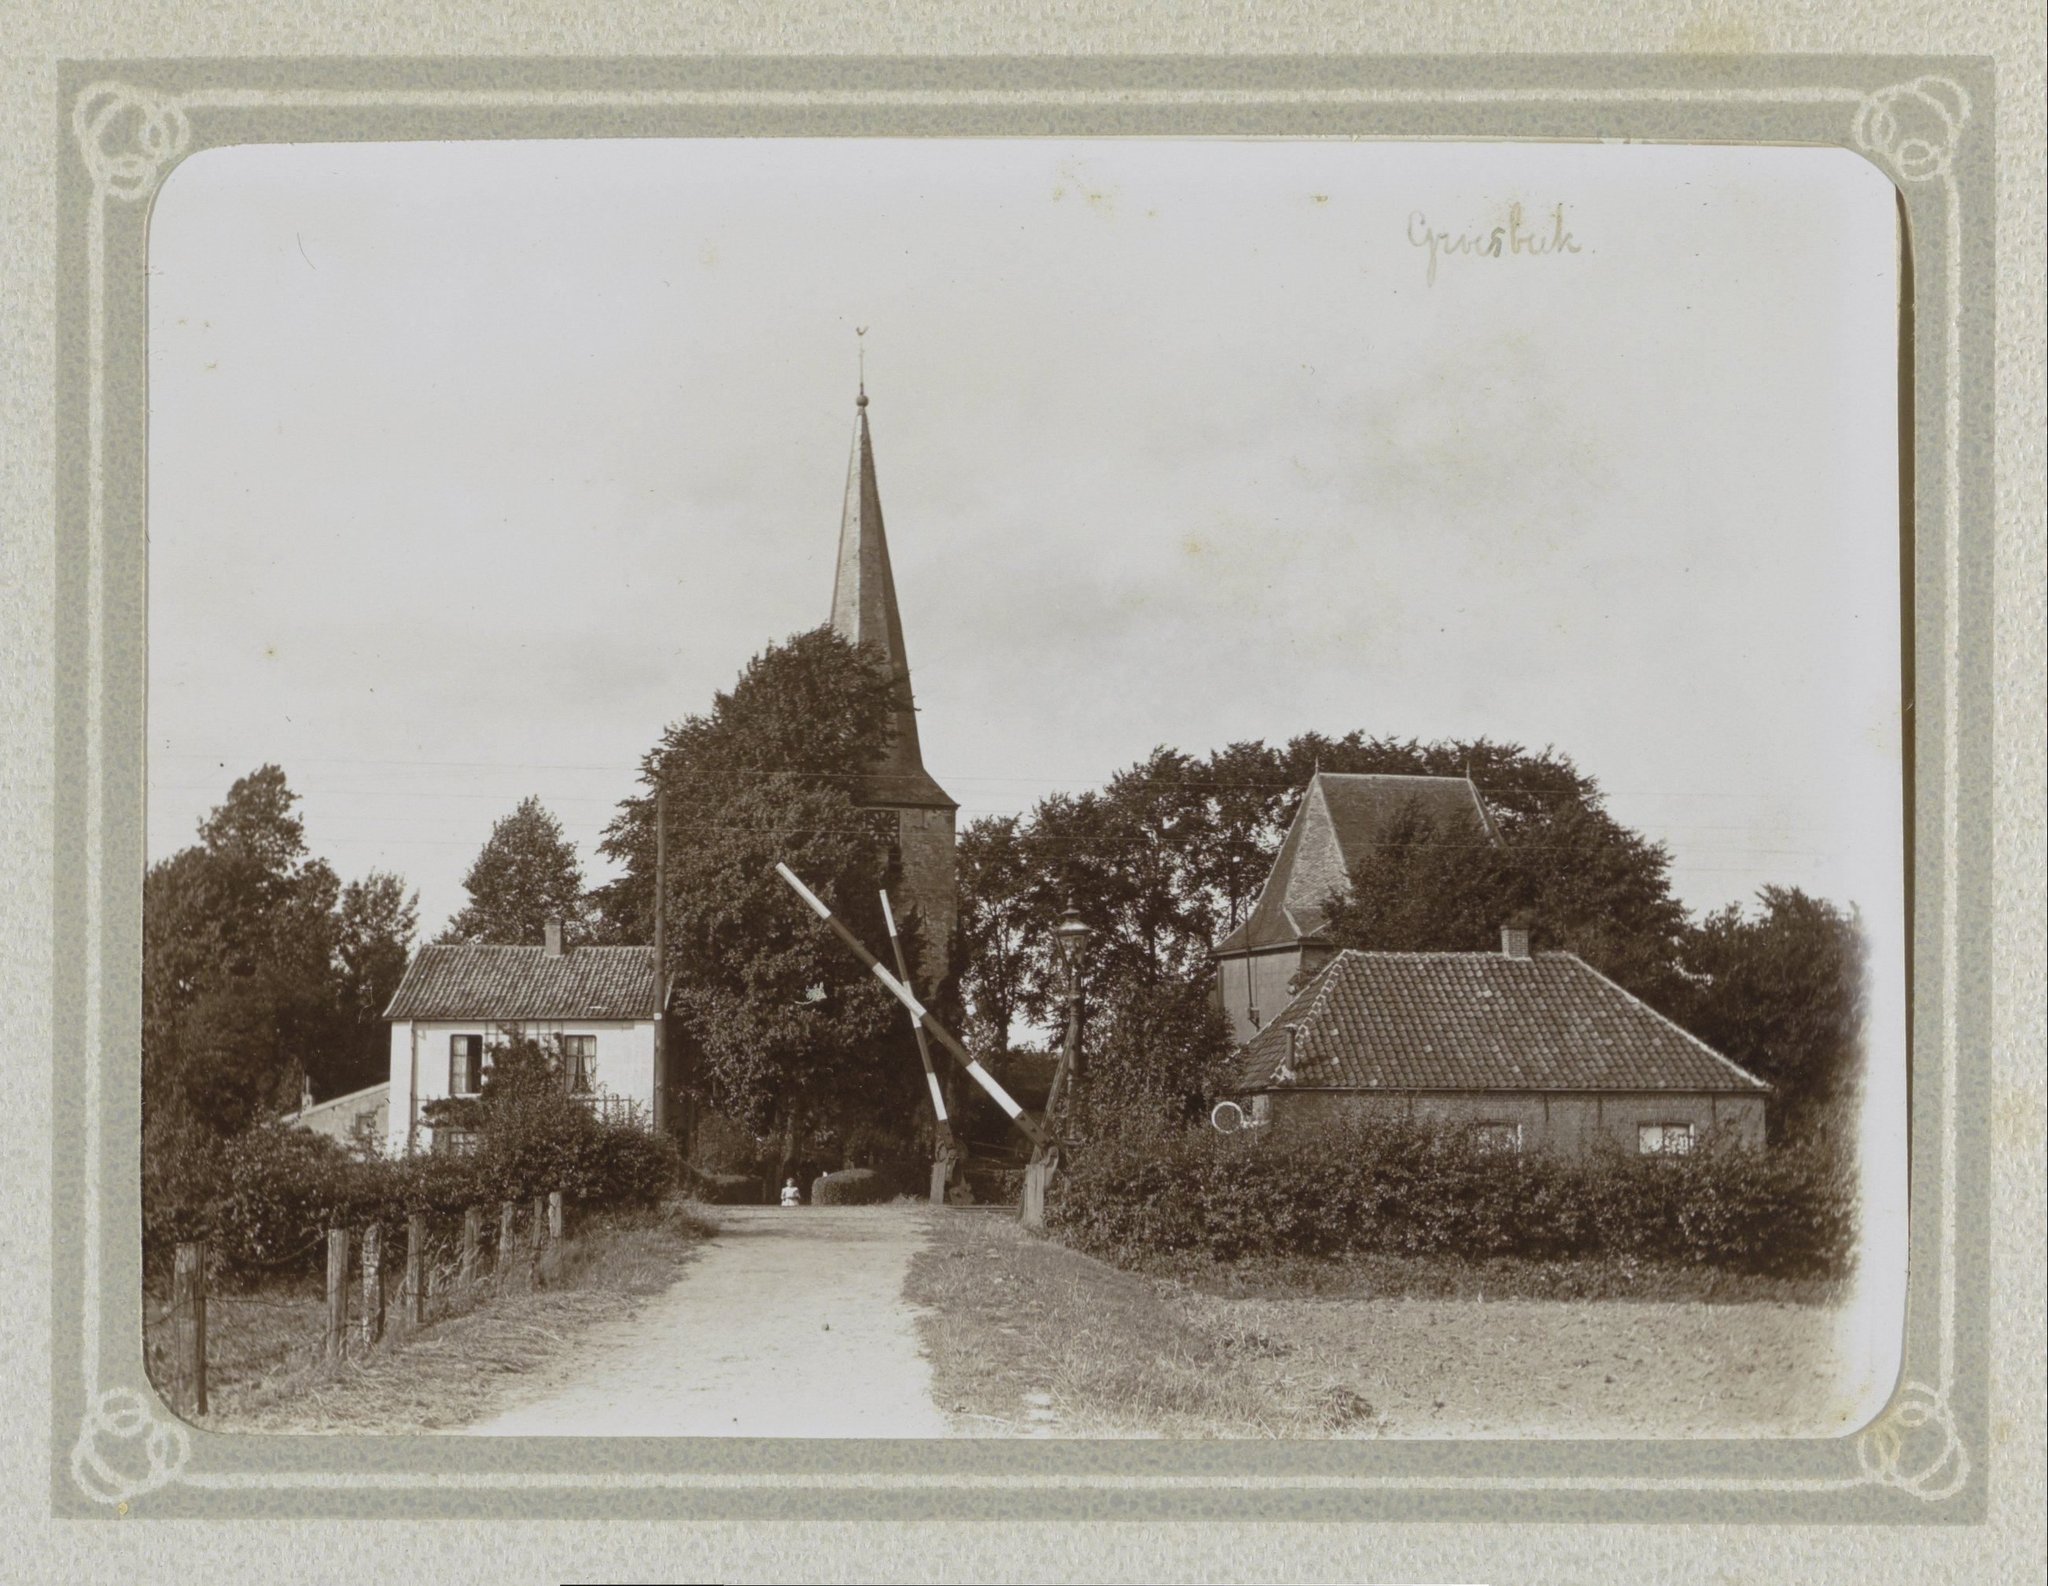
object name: photograph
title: Straat in Groesbeek met slagbomen, kerktoren en huizen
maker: folkert idzes de jong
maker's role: architect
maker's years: 1877-1929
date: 1905-1907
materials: photographic support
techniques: collodion silver print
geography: groesbeek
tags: barrier, village street, parts of church exterior and annexes: tower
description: Onderdeel van Topografisch album van Nederlandse dorpen en steden 1905.